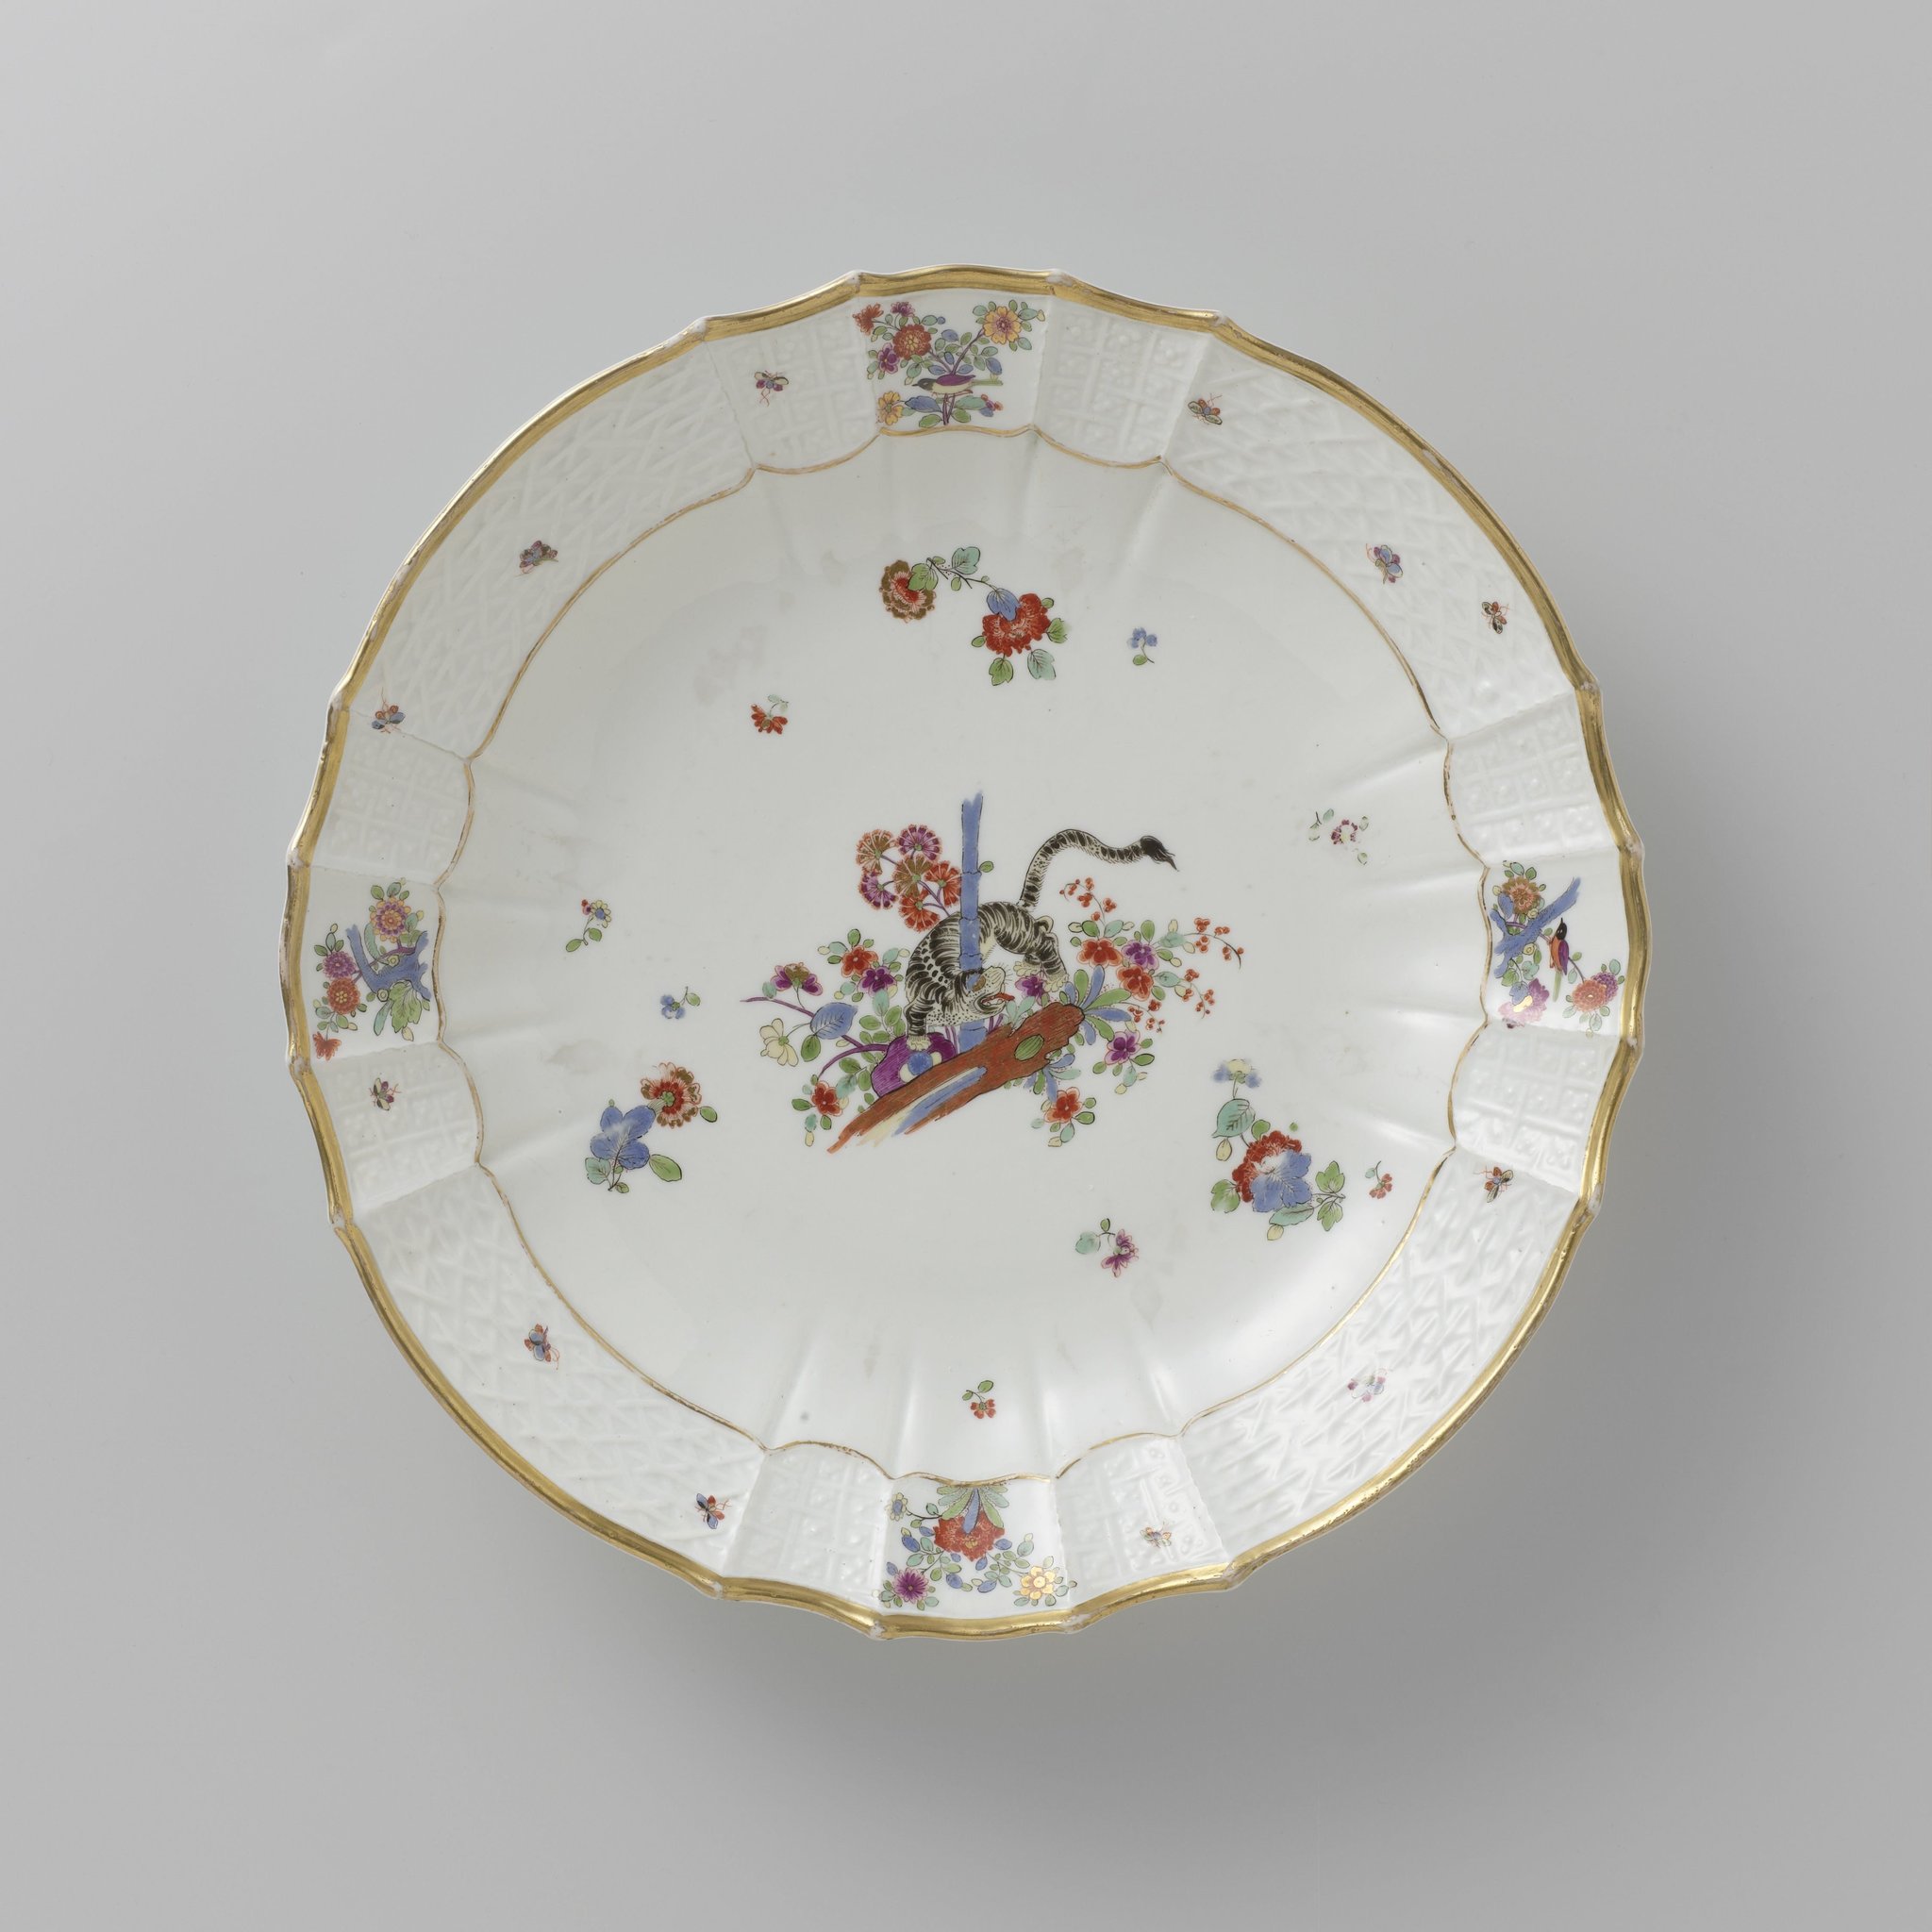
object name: platter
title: Schotel, veelkleurig beschilderd met een Kakiemon-decor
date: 1740-1745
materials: porcelain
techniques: painted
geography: meissen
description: Ronde schotel van beschilderd porselein. De schotel heeft een geribde en geschulpte rand. De schotel is beschilderd met een tijger om een bamboestengel, gestrooide Indianische Blumen, vlinders en takken met vogels. De rand is versierd met het 'Altbrandenstein'-patroon. De schotel is gemerkt.